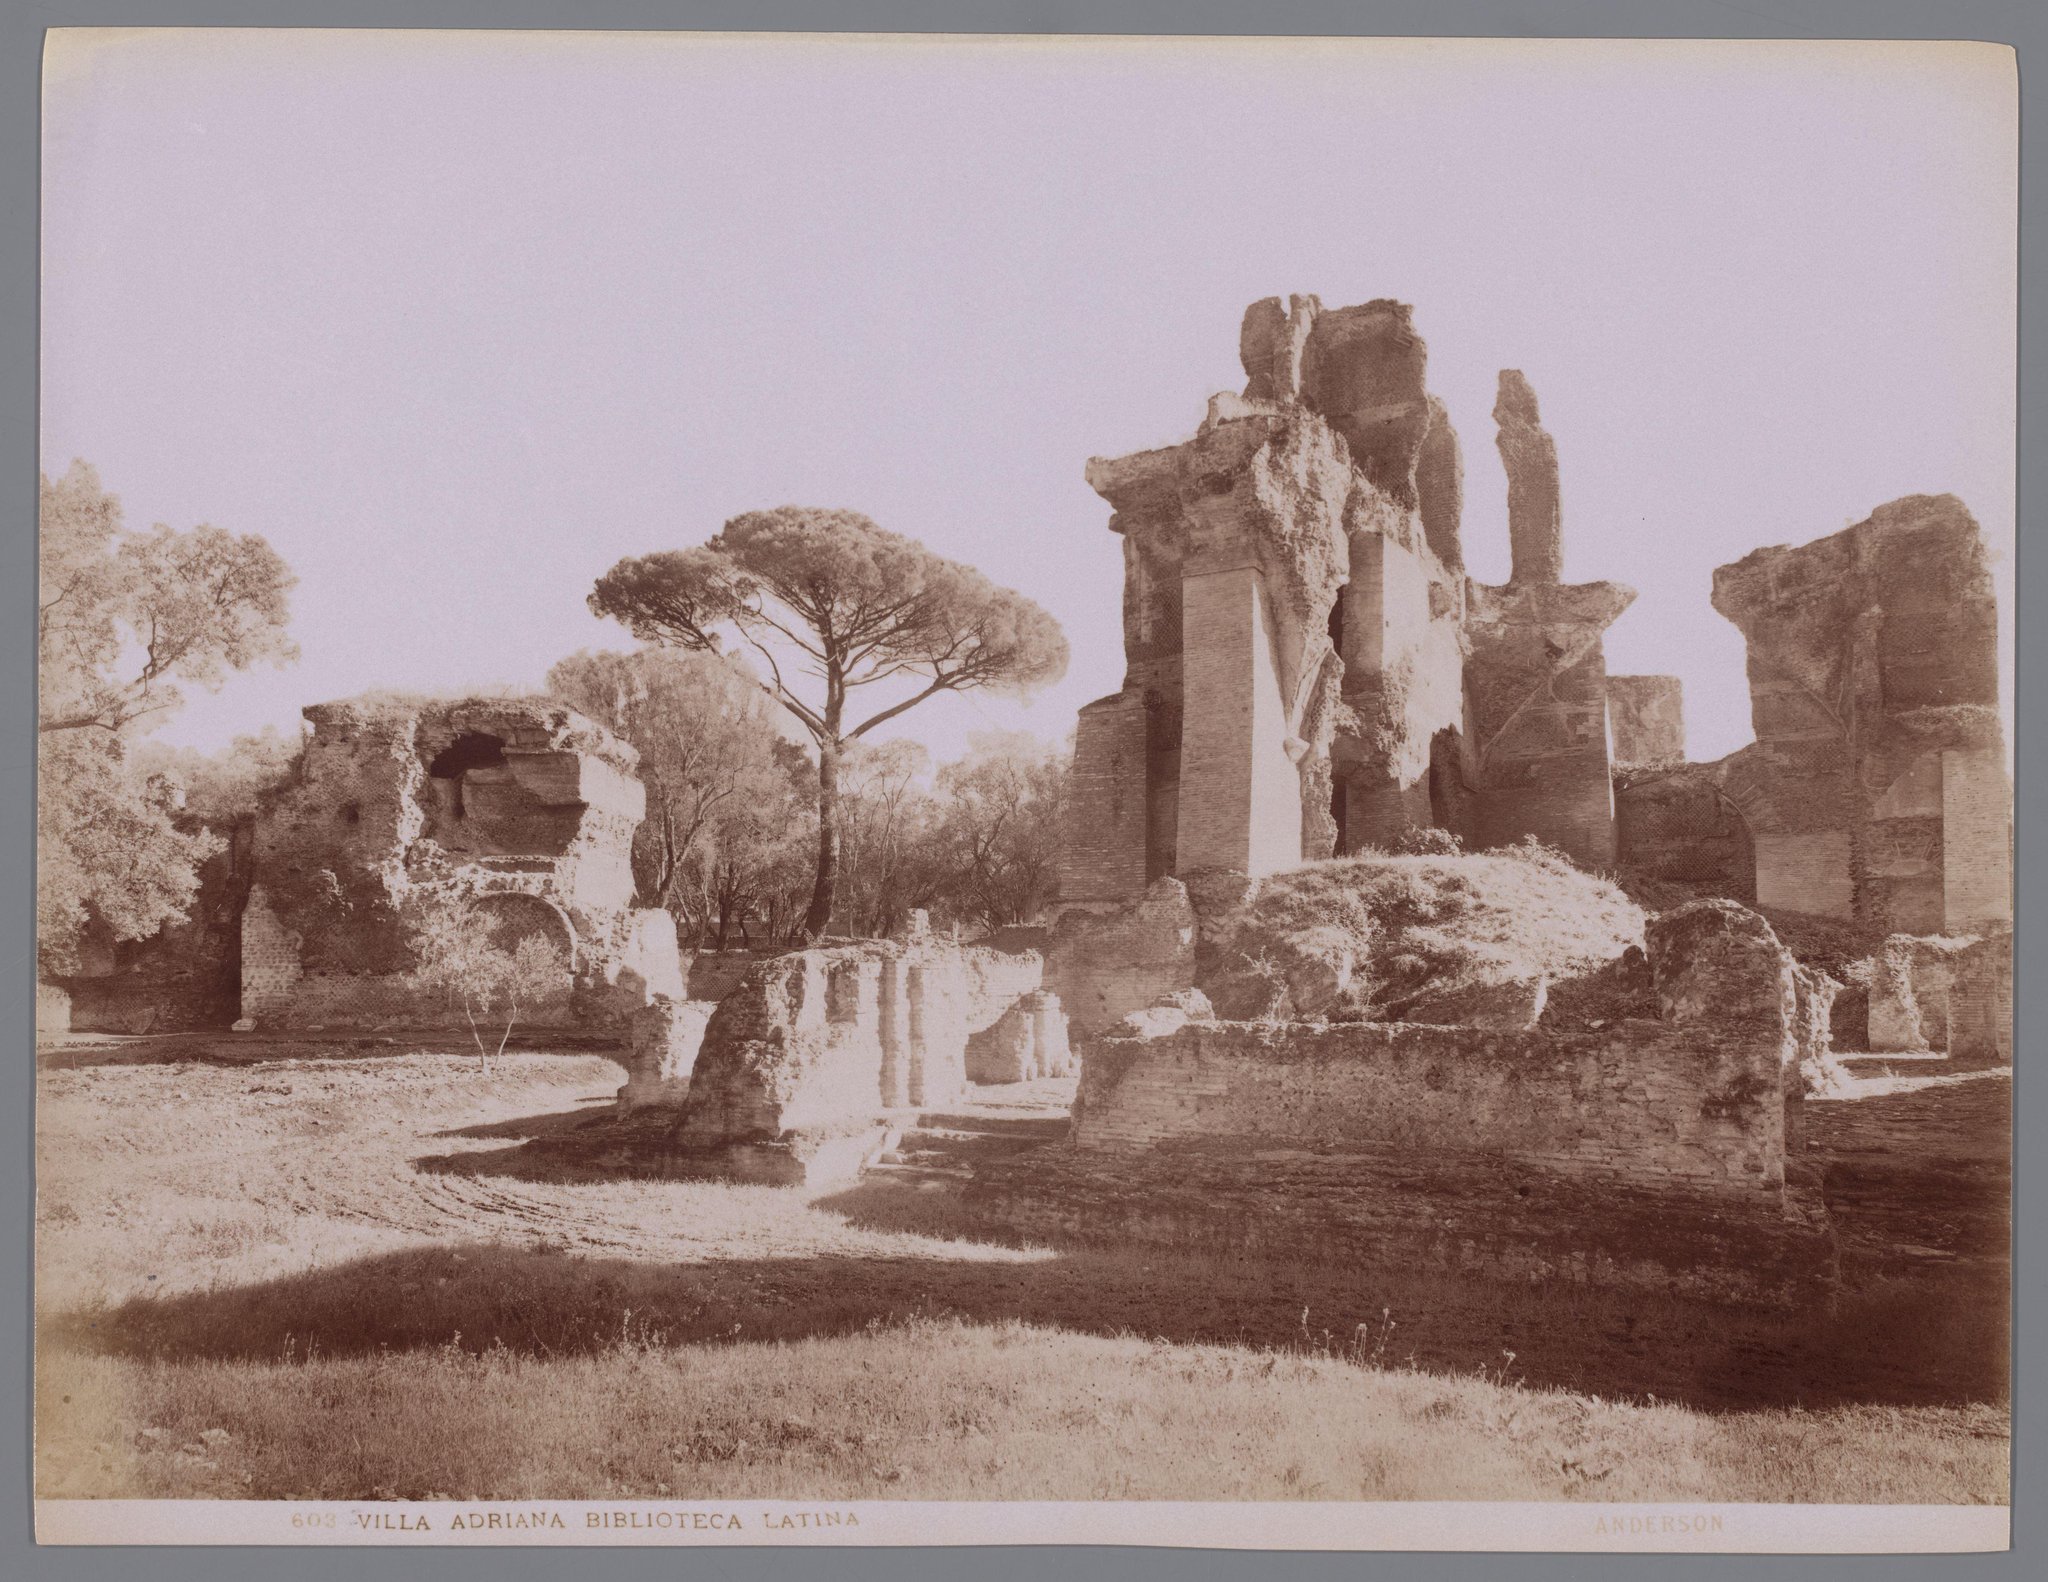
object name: photograph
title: Villa Adriana Biblioteca Latina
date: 1860-1900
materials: paper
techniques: albumen print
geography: tivoli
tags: landscape with ruins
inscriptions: number: ‘603’, collector's mark: ‘VOSMAER’